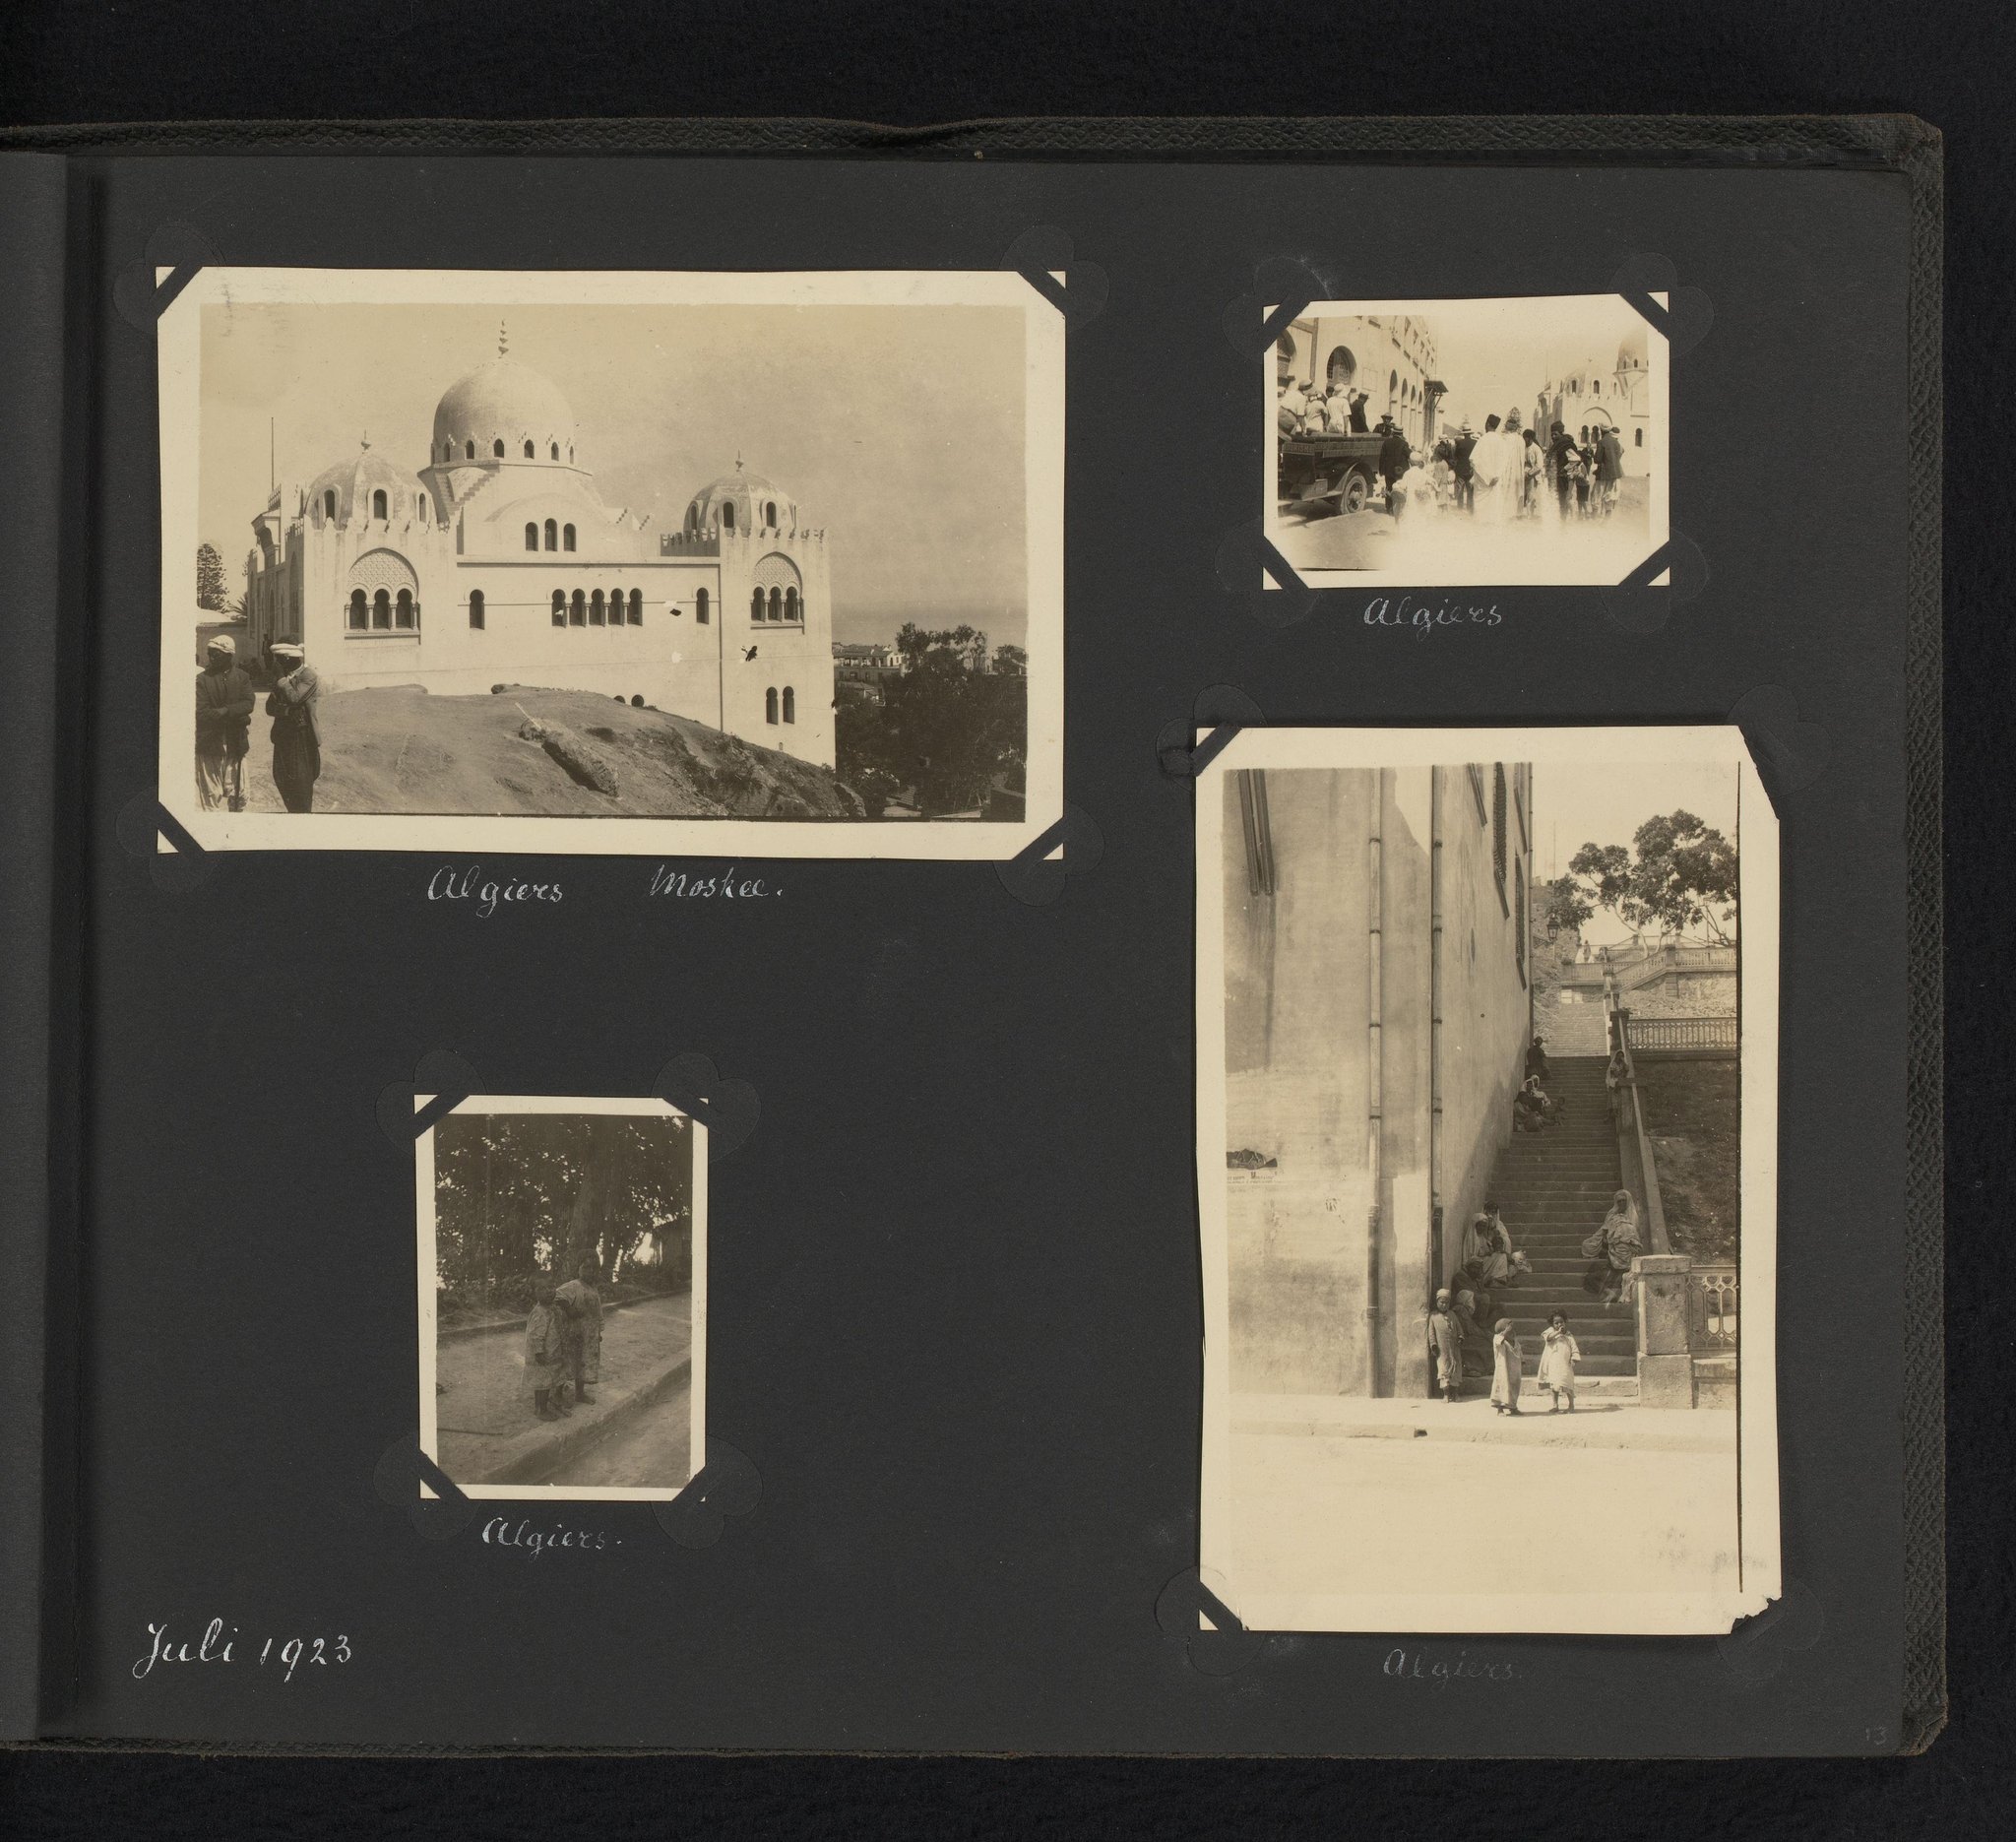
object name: photograph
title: Juli 1923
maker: hendrik herman van den berg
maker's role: amateurfotograaf, jurist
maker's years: 1875-1944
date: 1907-1923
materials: paper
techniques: gelatin silver print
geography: algiers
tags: temple, shrine ~ islam, mohammedanism, street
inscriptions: inscription: ‘Algiers’, inscription: ‘Algiers’, inscription: ‘Algiers’, inscription: ‘Algiers Moskee’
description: Deze foto's maken deel uit van een album.